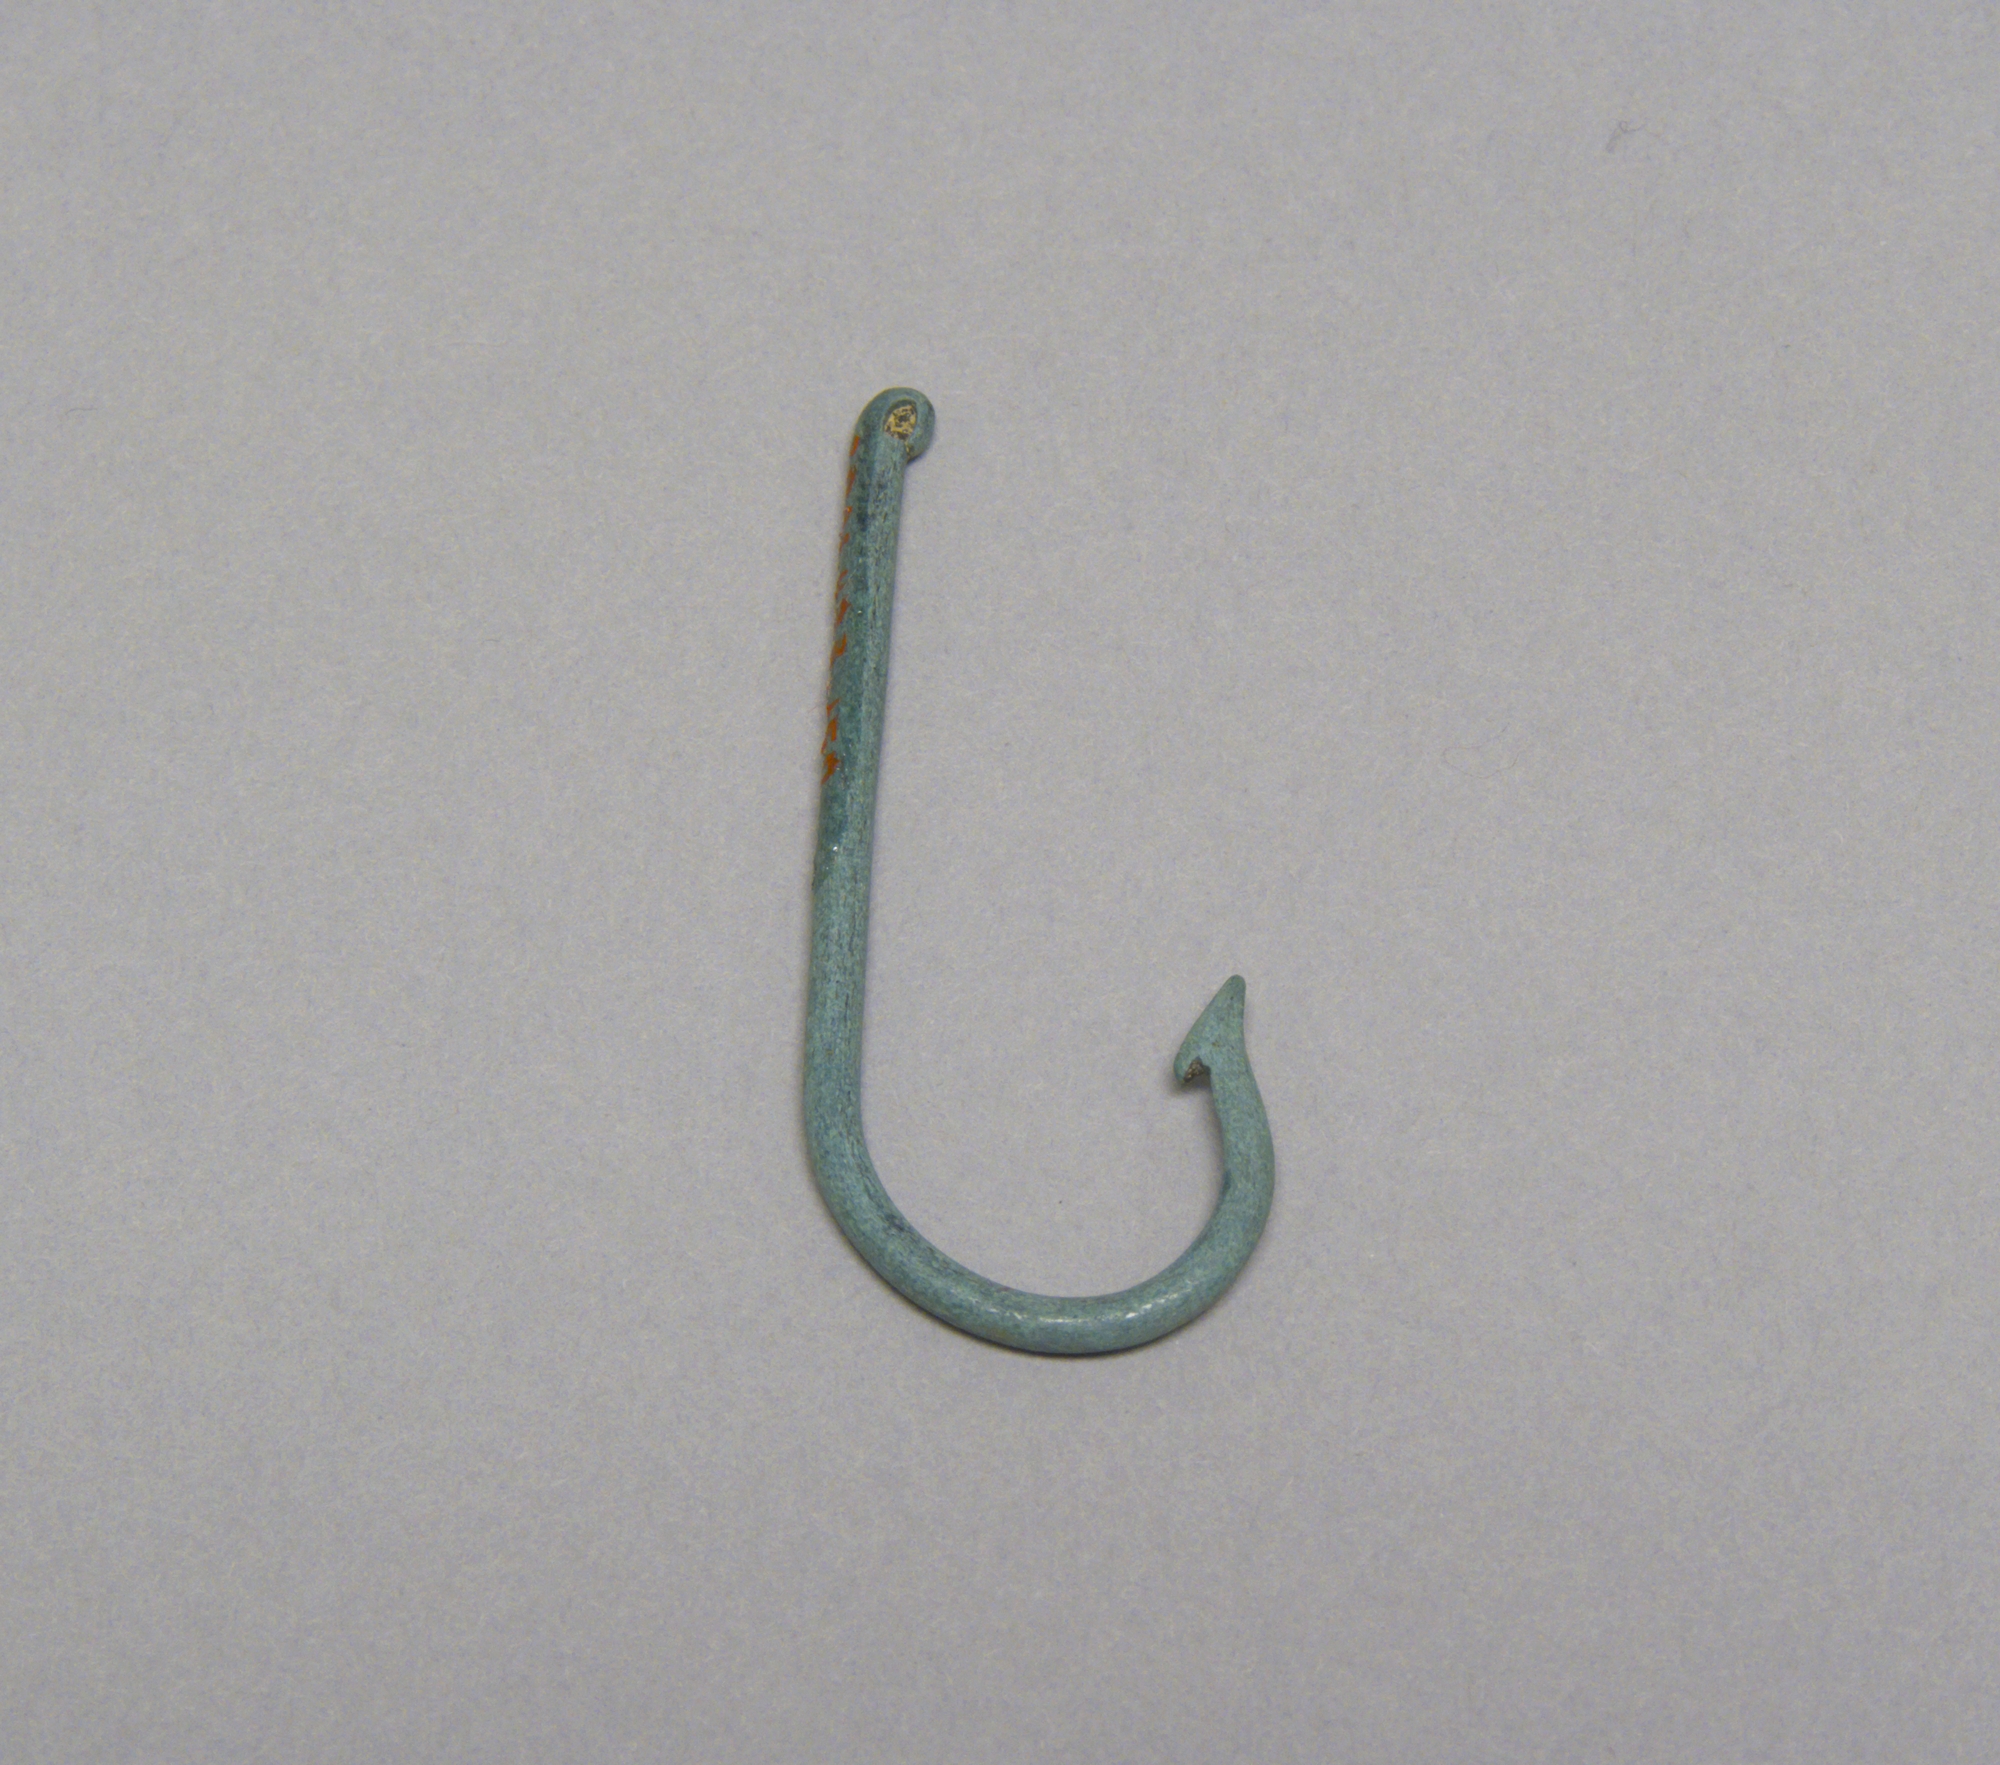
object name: hook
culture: thai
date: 500 BCE-300 CE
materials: bronze